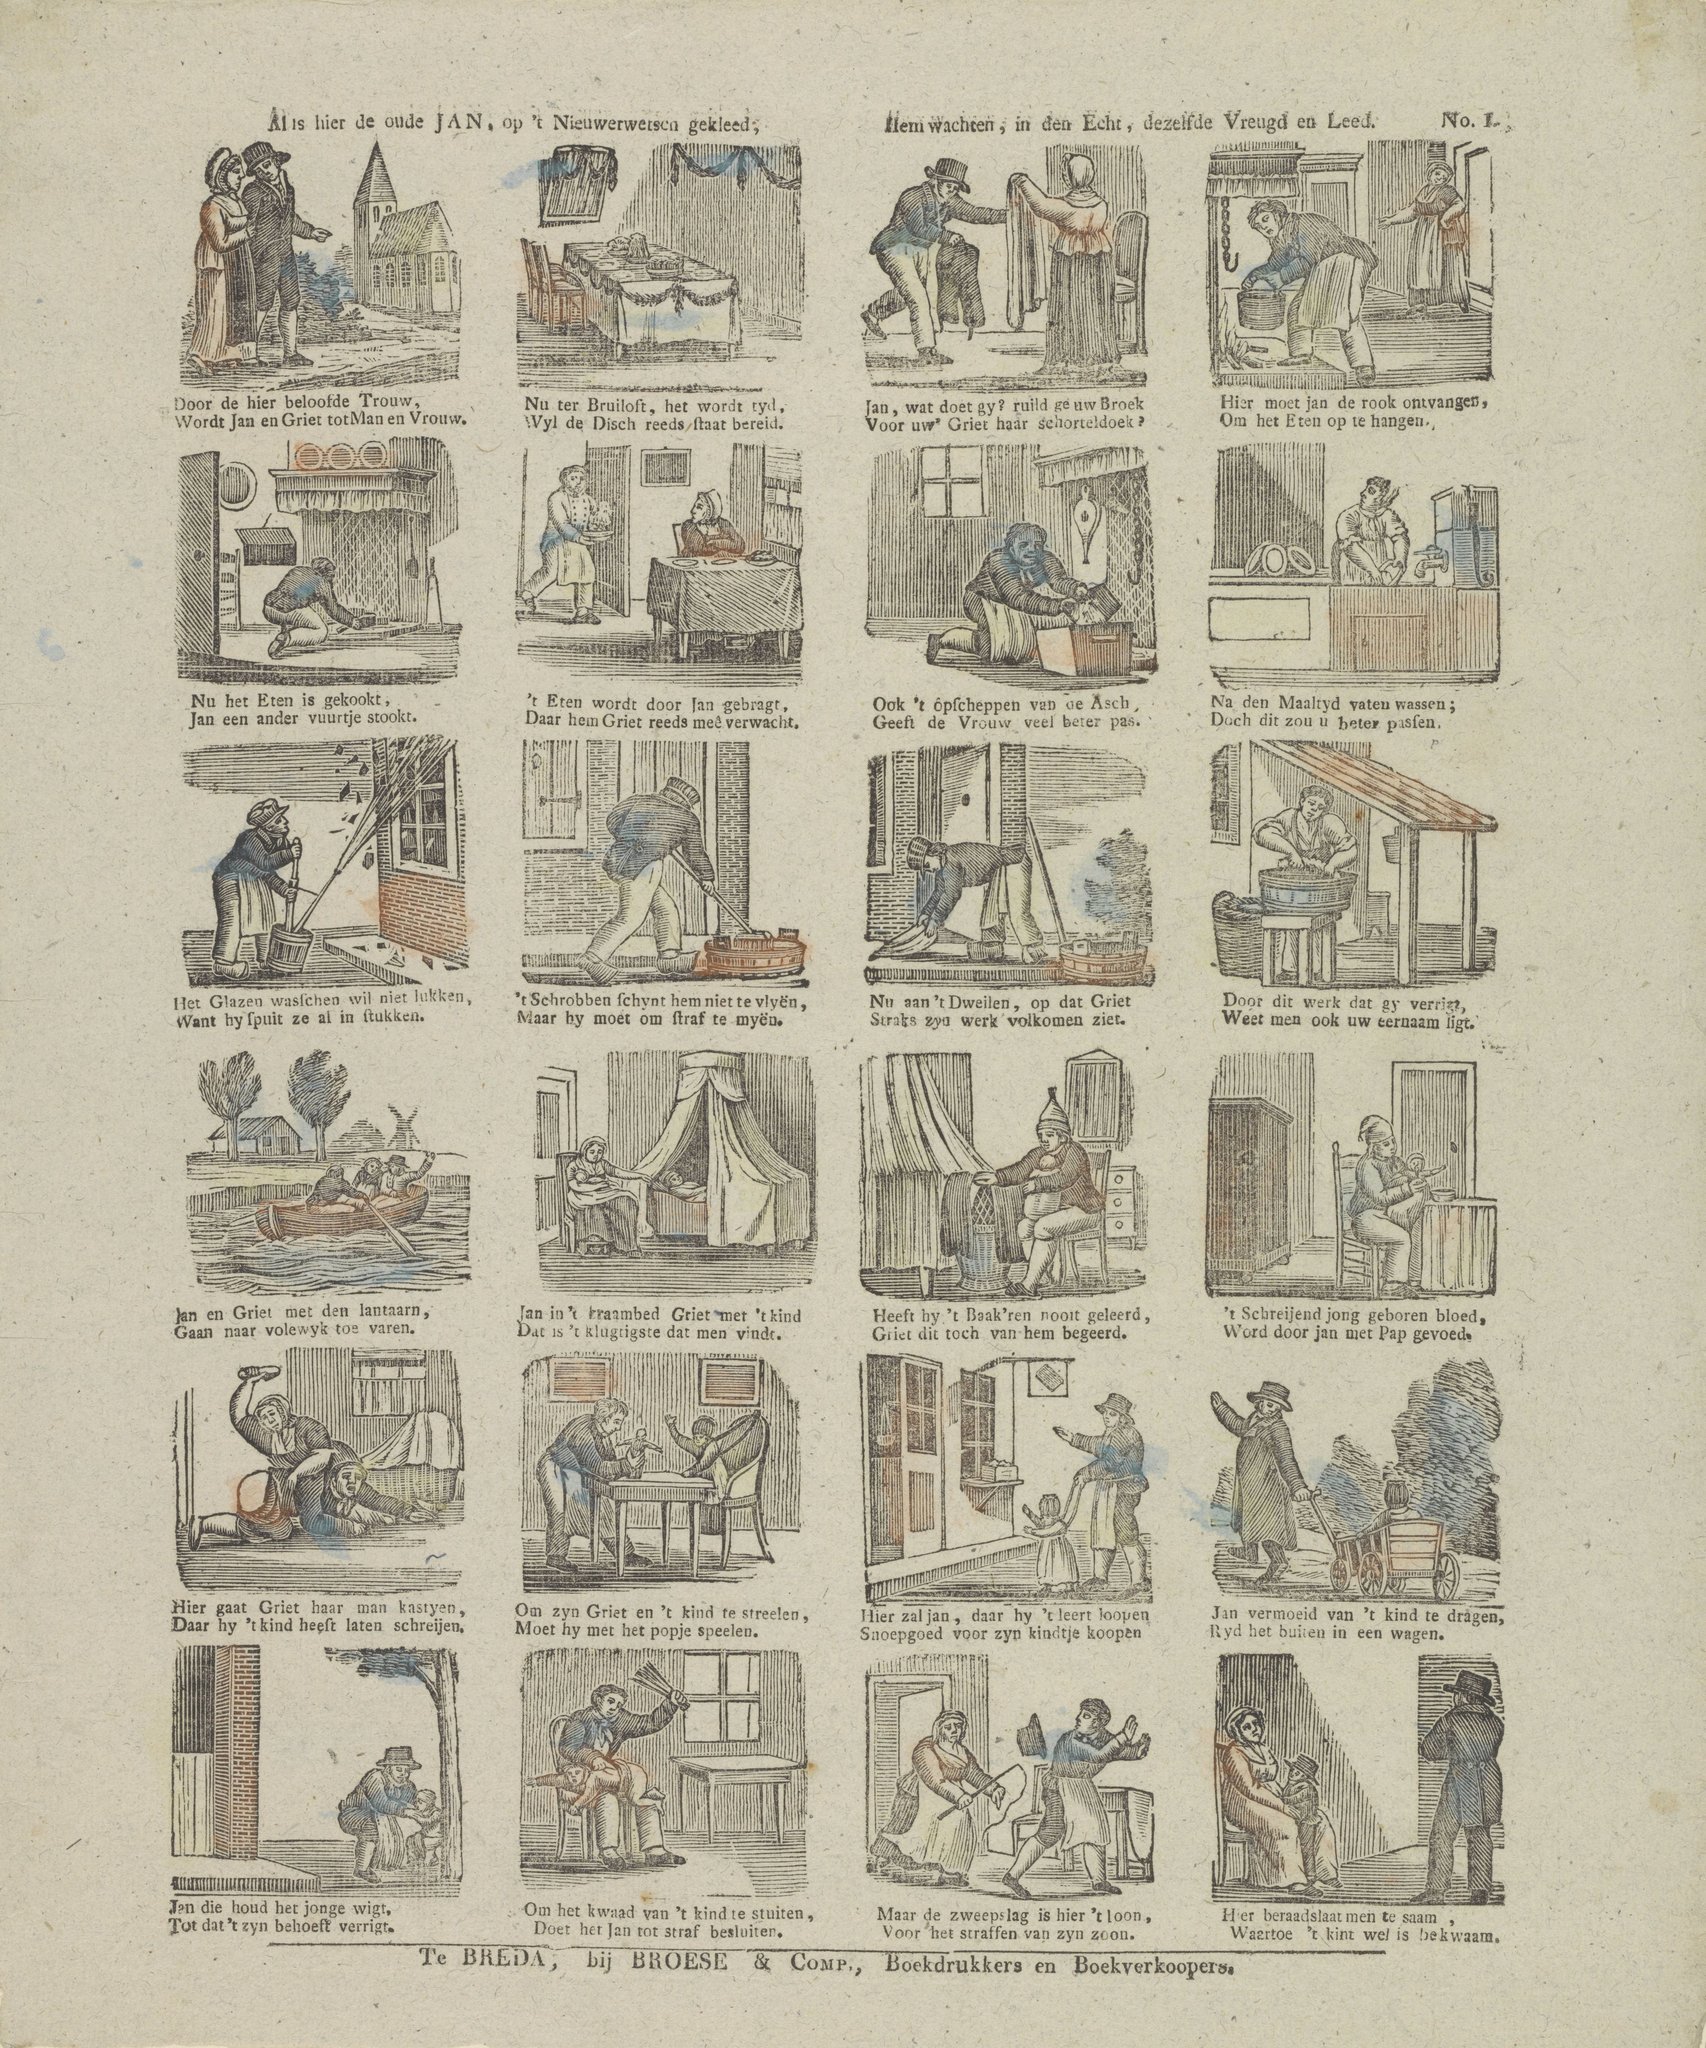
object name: popular print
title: Al is hier de oude Jan, op 't nieuwerwetsch gekleed, / Hem wachten, in den echt, dezelfde vreugd en leed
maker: Anonymous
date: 1828-1853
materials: paper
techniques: colour, letterpress printing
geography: breda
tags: hen-pecked husband, 'betty', 'molly' (man who engages in women's work)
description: Blad met 24 voorstellingen uit het leven van Jan de Wasser, een man die van zijn vrouw Griet, die de broek aan heeft, al het huishoudelijk werk moet doen. Onder elke voorstelling een tweeregelig vers. Genummerd rechtsboven: No. 1.